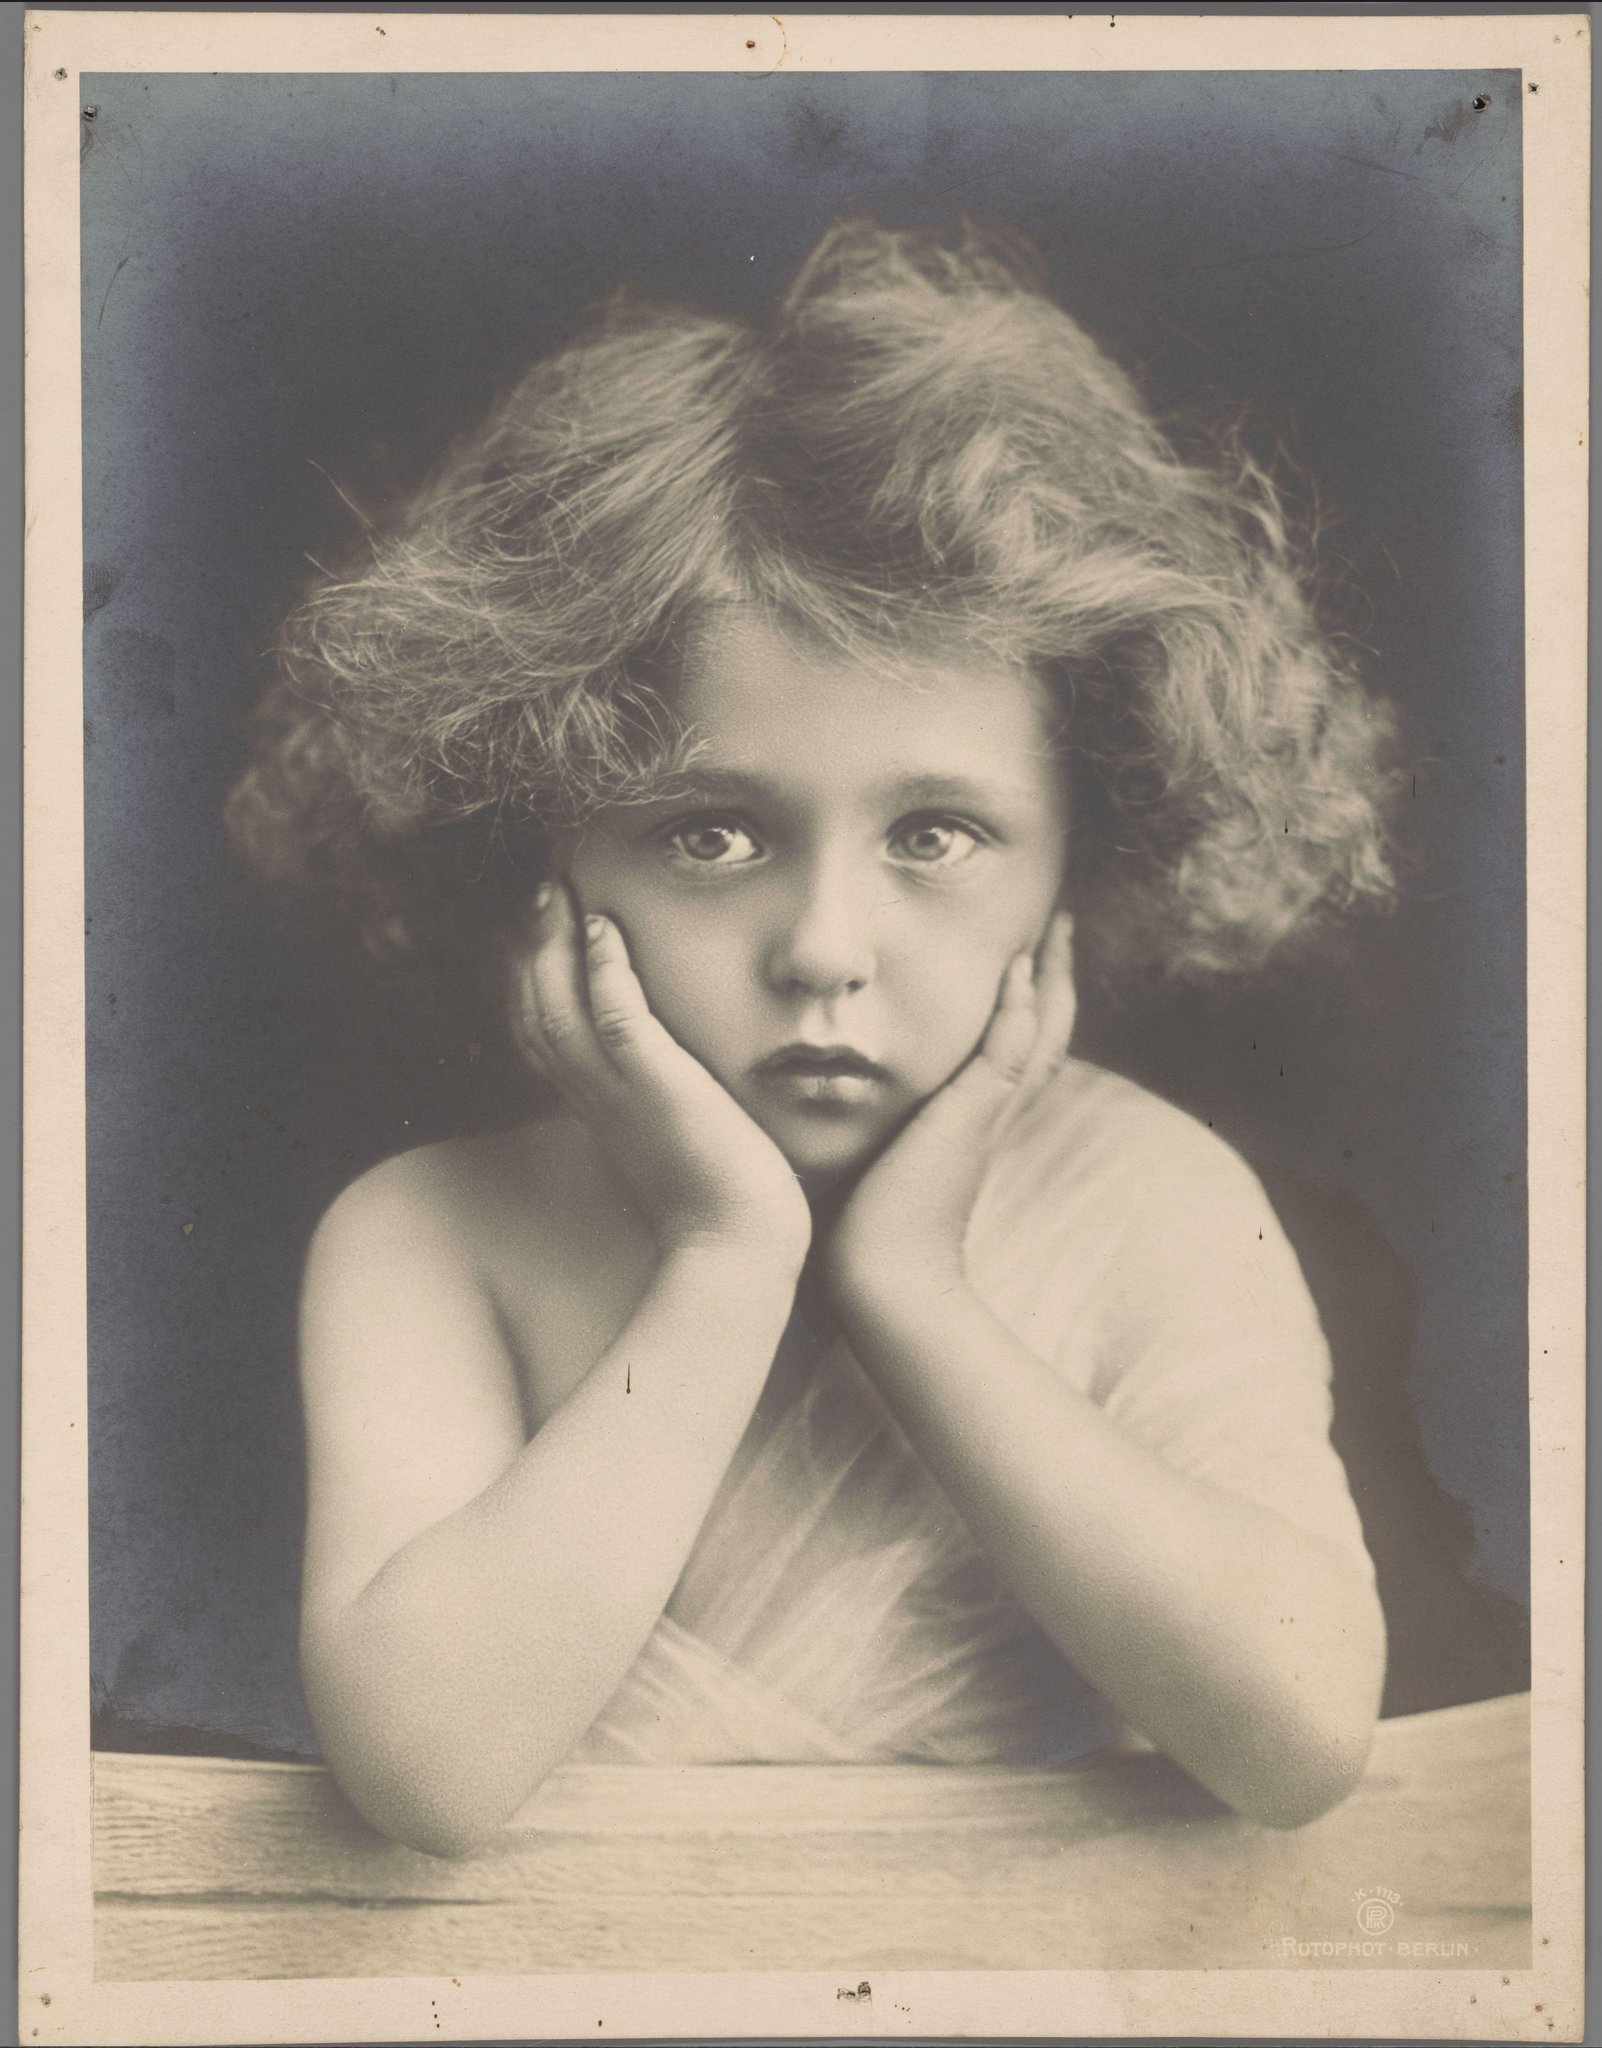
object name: photograph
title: Portret van een onbekend kind met hoofd in de handen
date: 1900-1930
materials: paper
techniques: gelatin silver print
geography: berlin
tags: child, anonymous historical person portrayed, berlin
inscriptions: inscription: ‘K-1113/ RPH/ Rotophot Berlin’